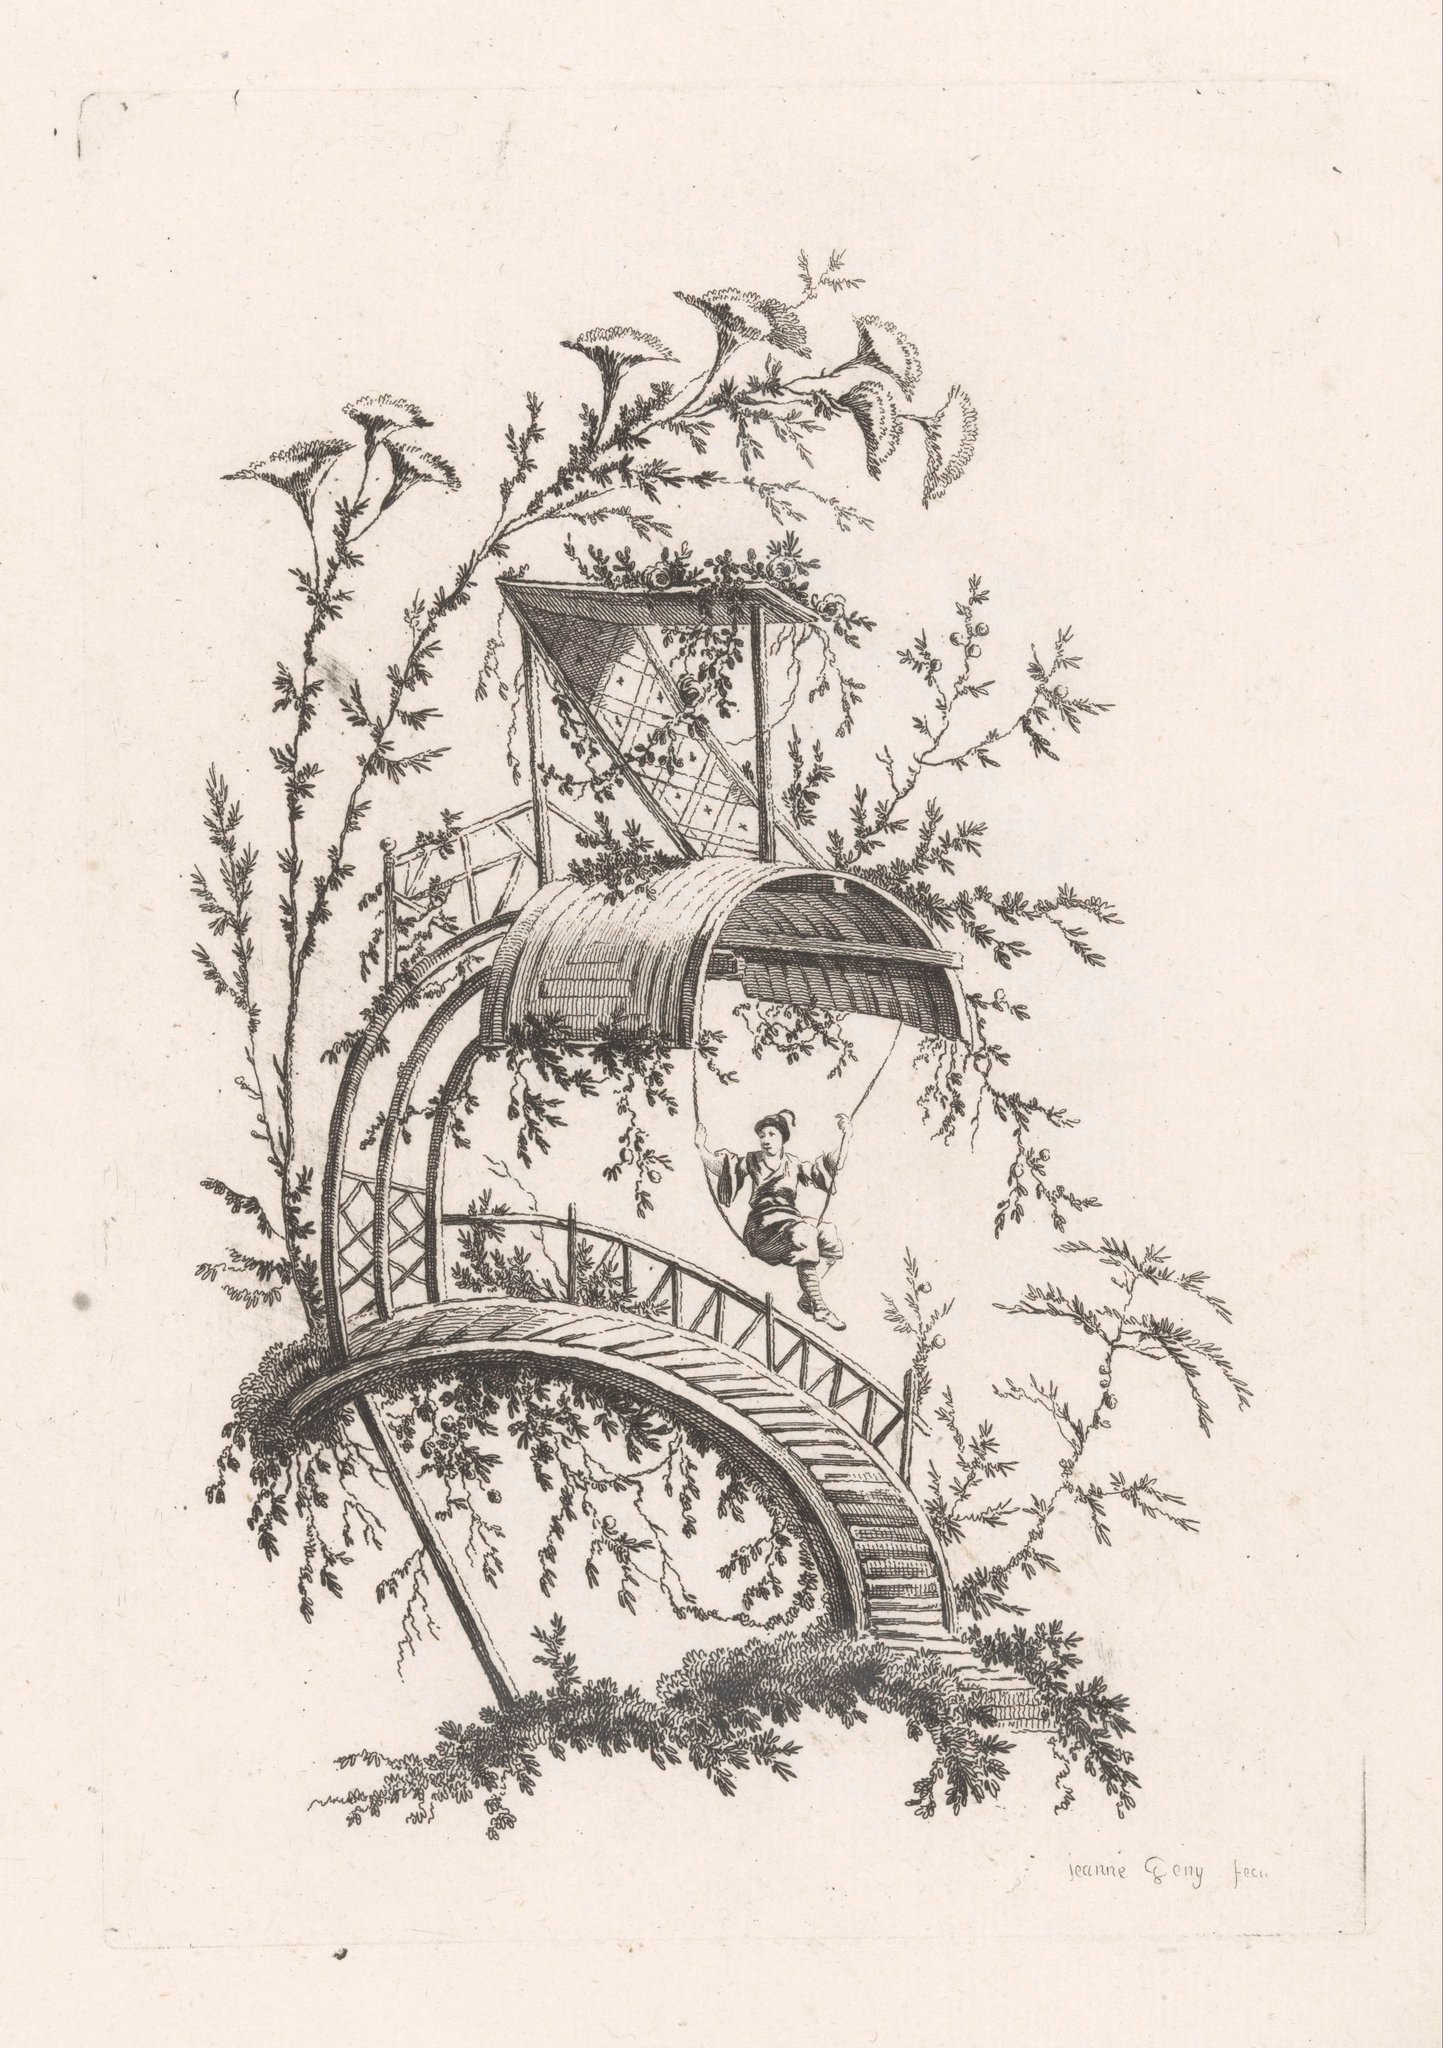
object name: ornament print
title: Man op schommel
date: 1770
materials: paper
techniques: etching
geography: paris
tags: sitting figure, swing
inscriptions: collector's mark: Lugt 2228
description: In een landschap zit een man onder een afdak op een schommel, onder hem een trap.